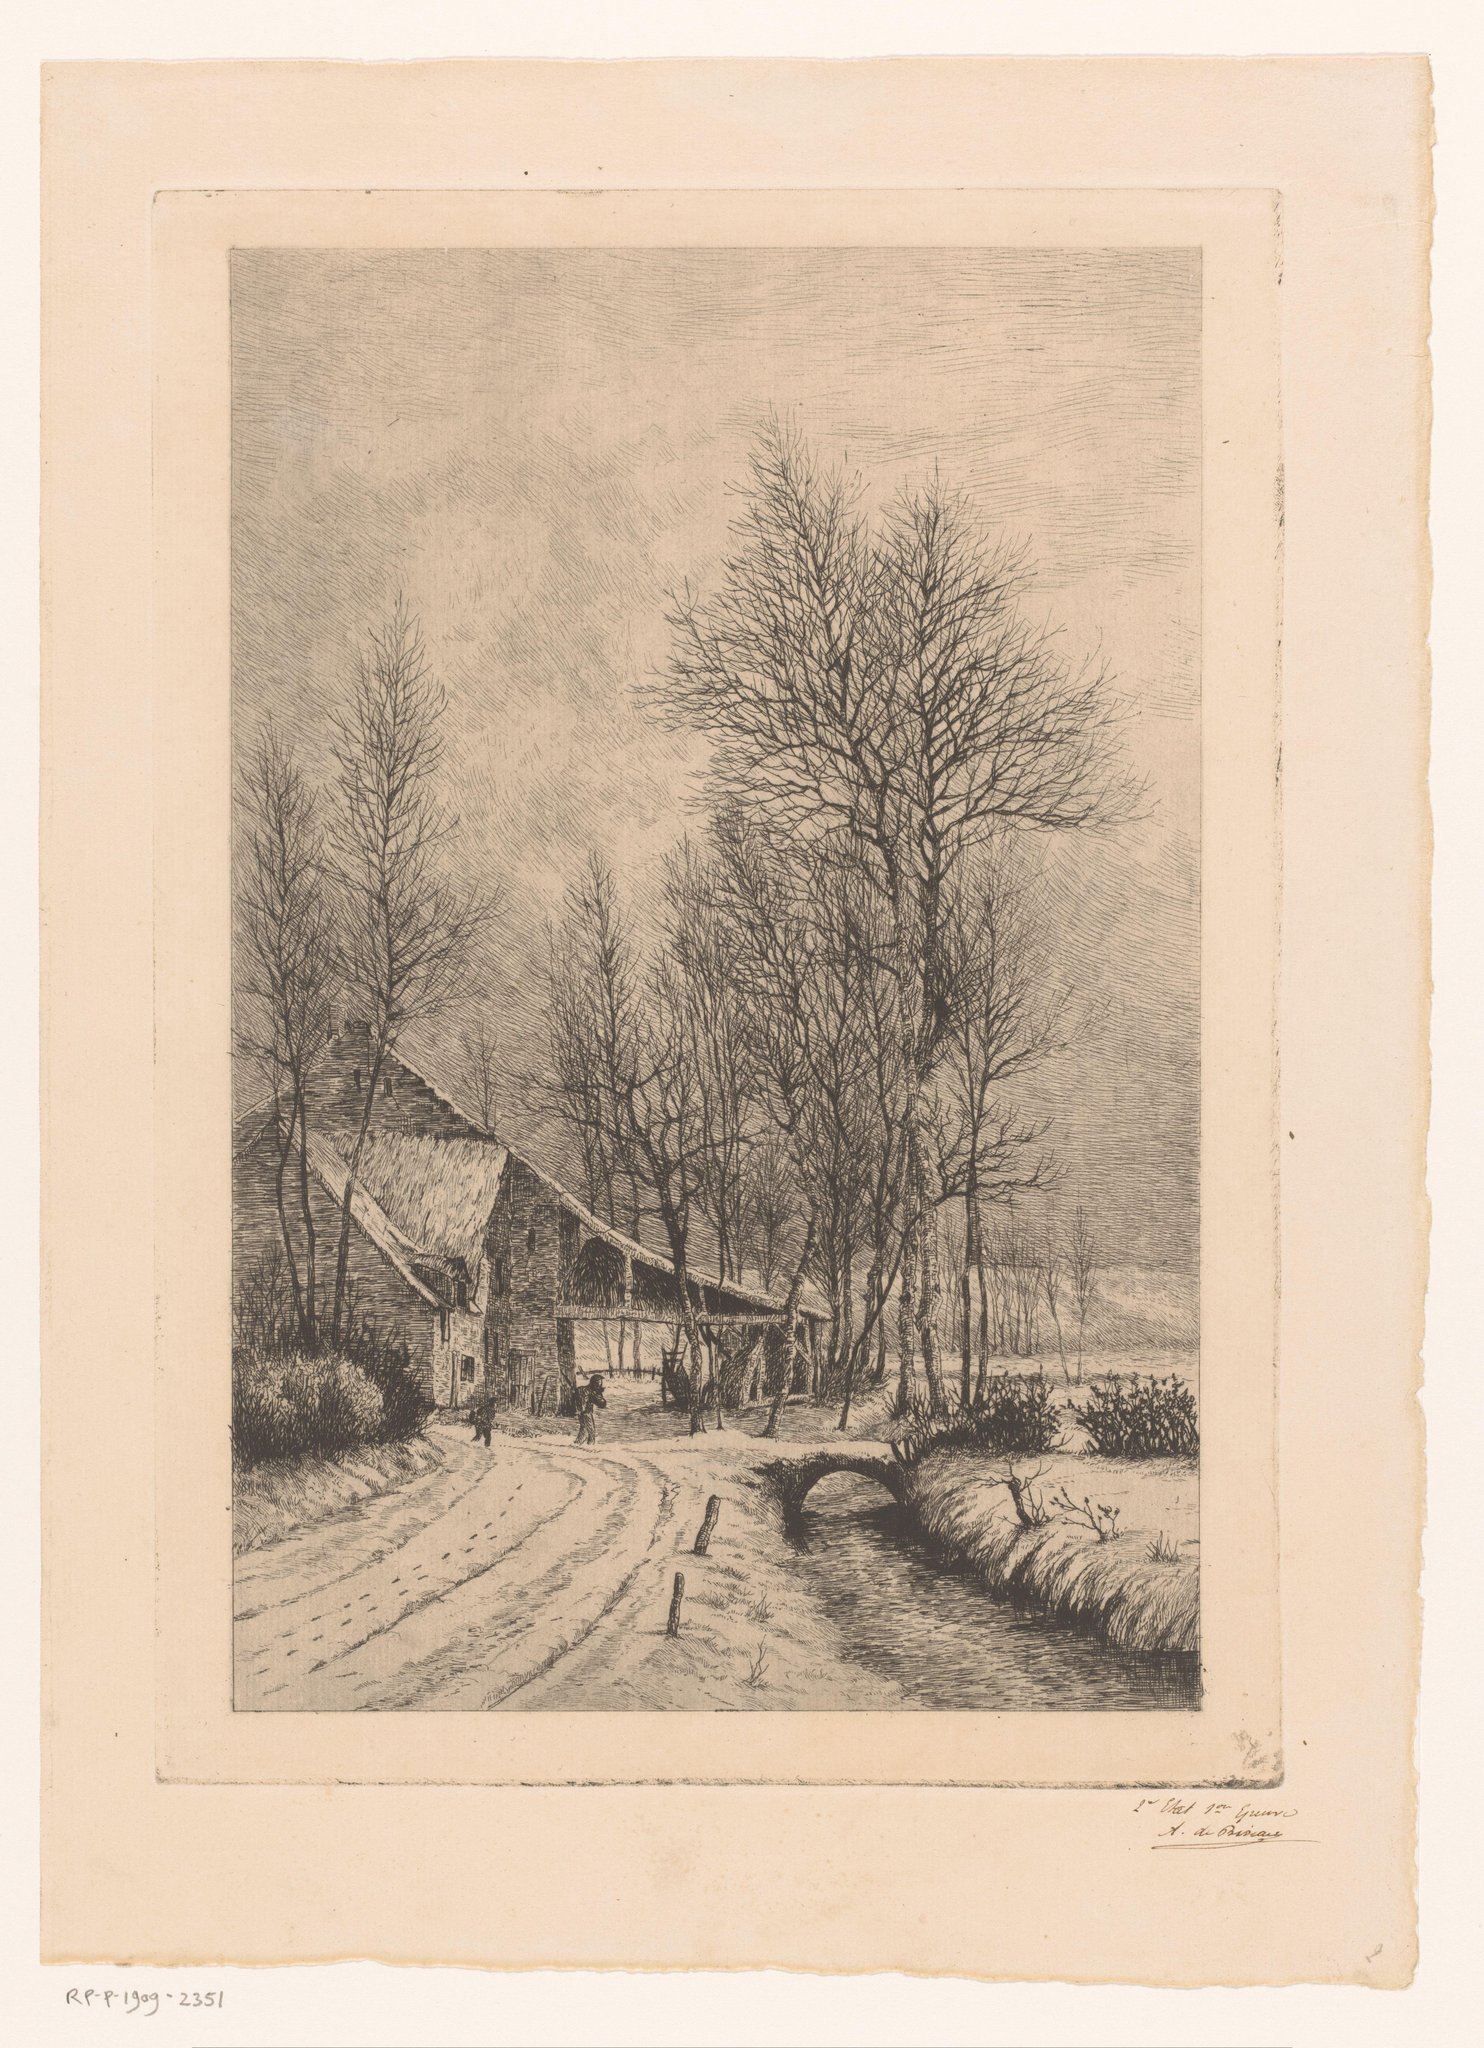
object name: print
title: Winterlandschap met boerenwoning gelegen in een bocht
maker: aristide de biseau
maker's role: print maker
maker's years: 1844-1883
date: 1854-1883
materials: paper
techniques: etching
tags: lizards, farm or solitary house in landscape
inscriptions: collector's mark: Lugt 2228, inscription: ‘2e Etat 1e Epreuve’